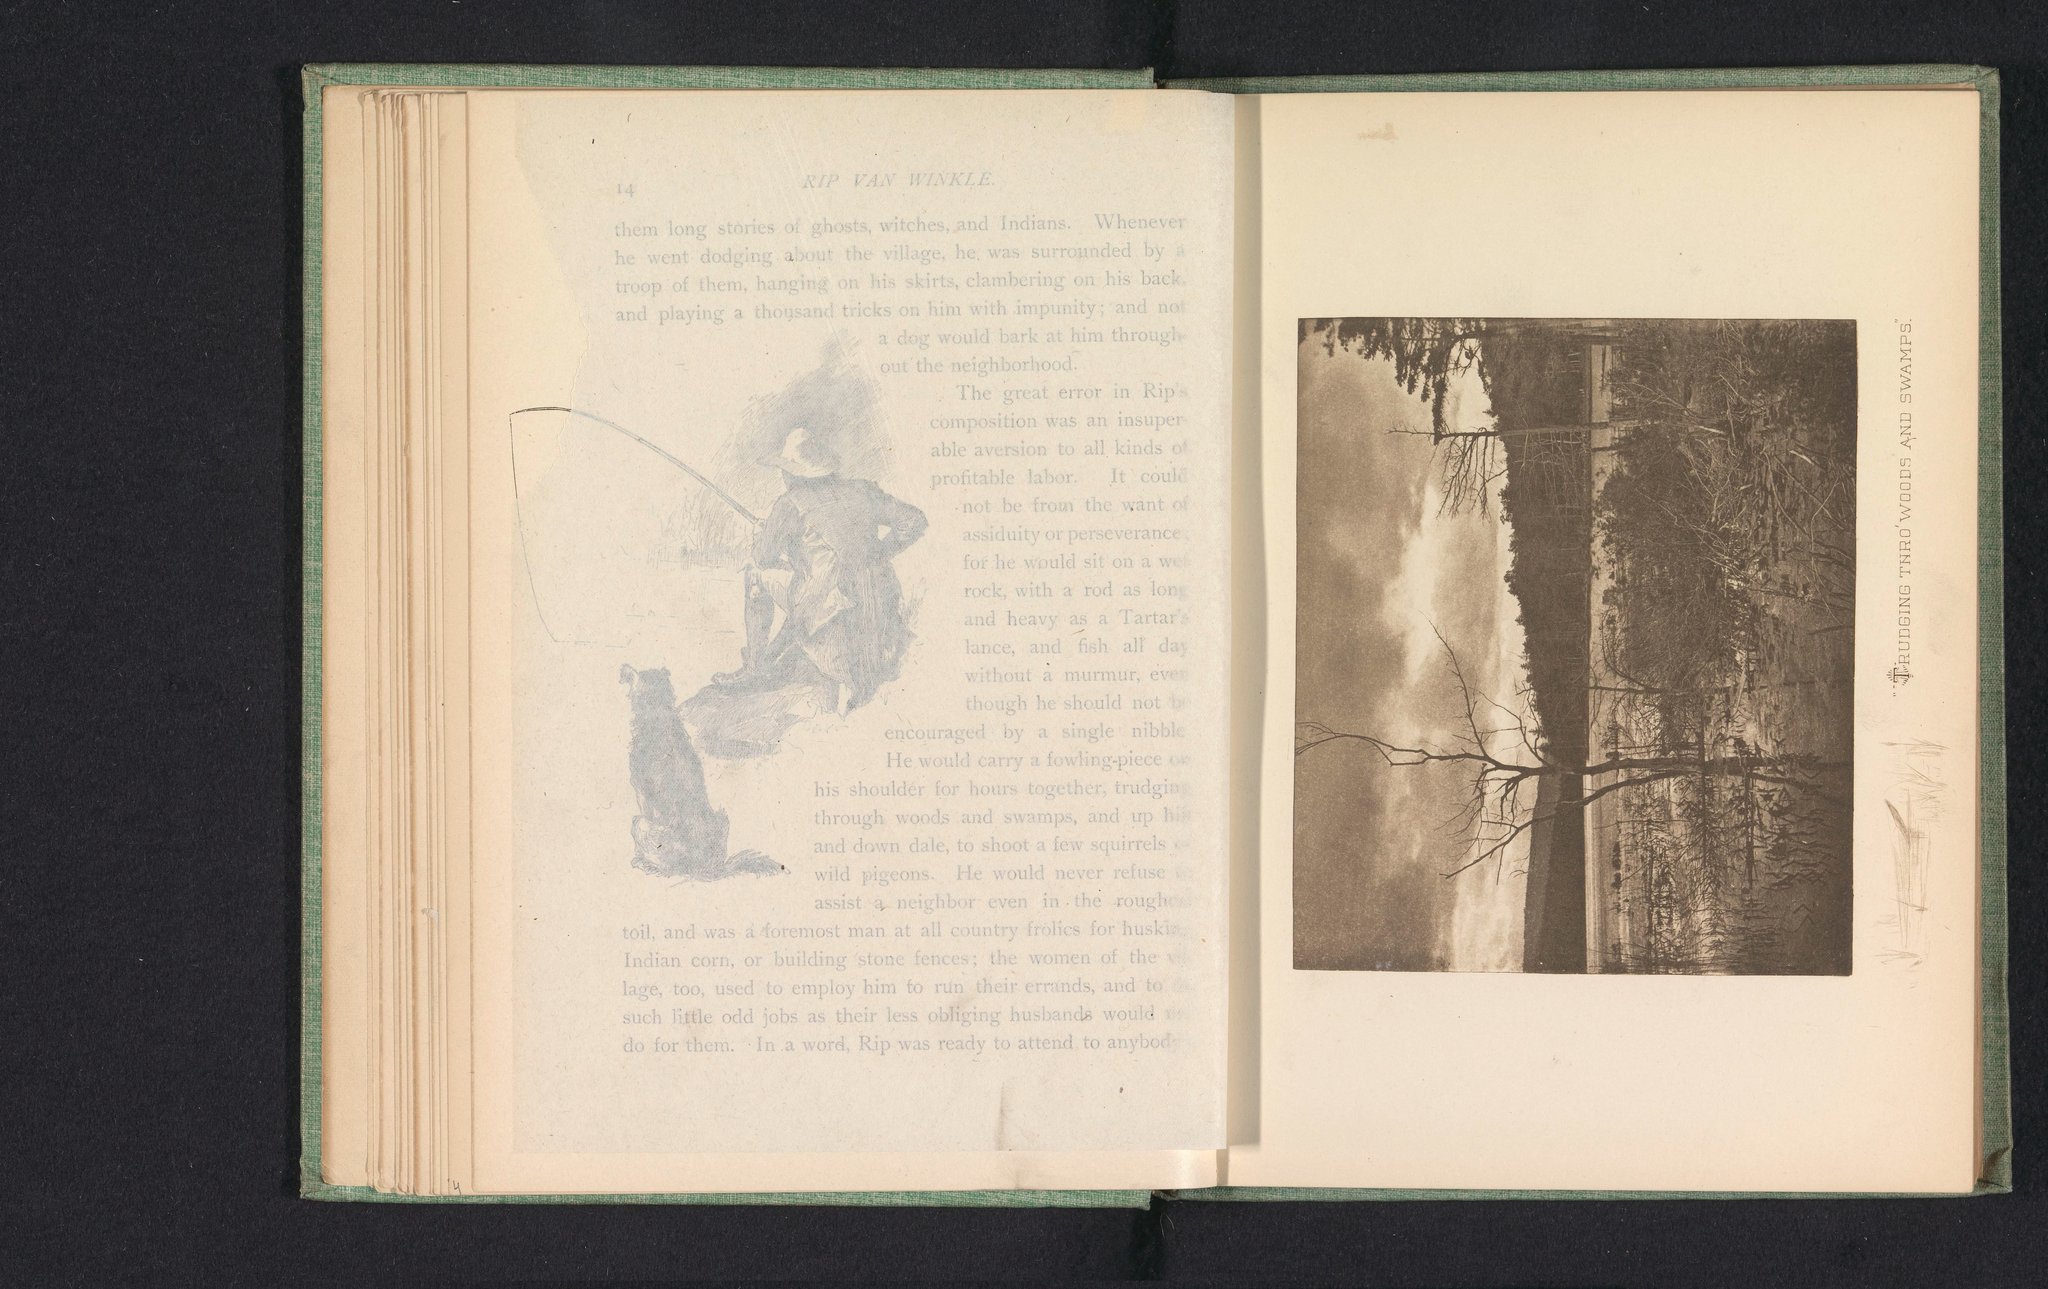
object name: page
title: Gezicht op een moeras in het Catskillgebergte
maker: Anonymous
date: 1884-1894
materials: paper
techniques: photoaquatint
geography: catskill mountains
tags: swamps and polders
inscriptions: inscription: ‘“Trudging thro 'woods and swamps'.”’